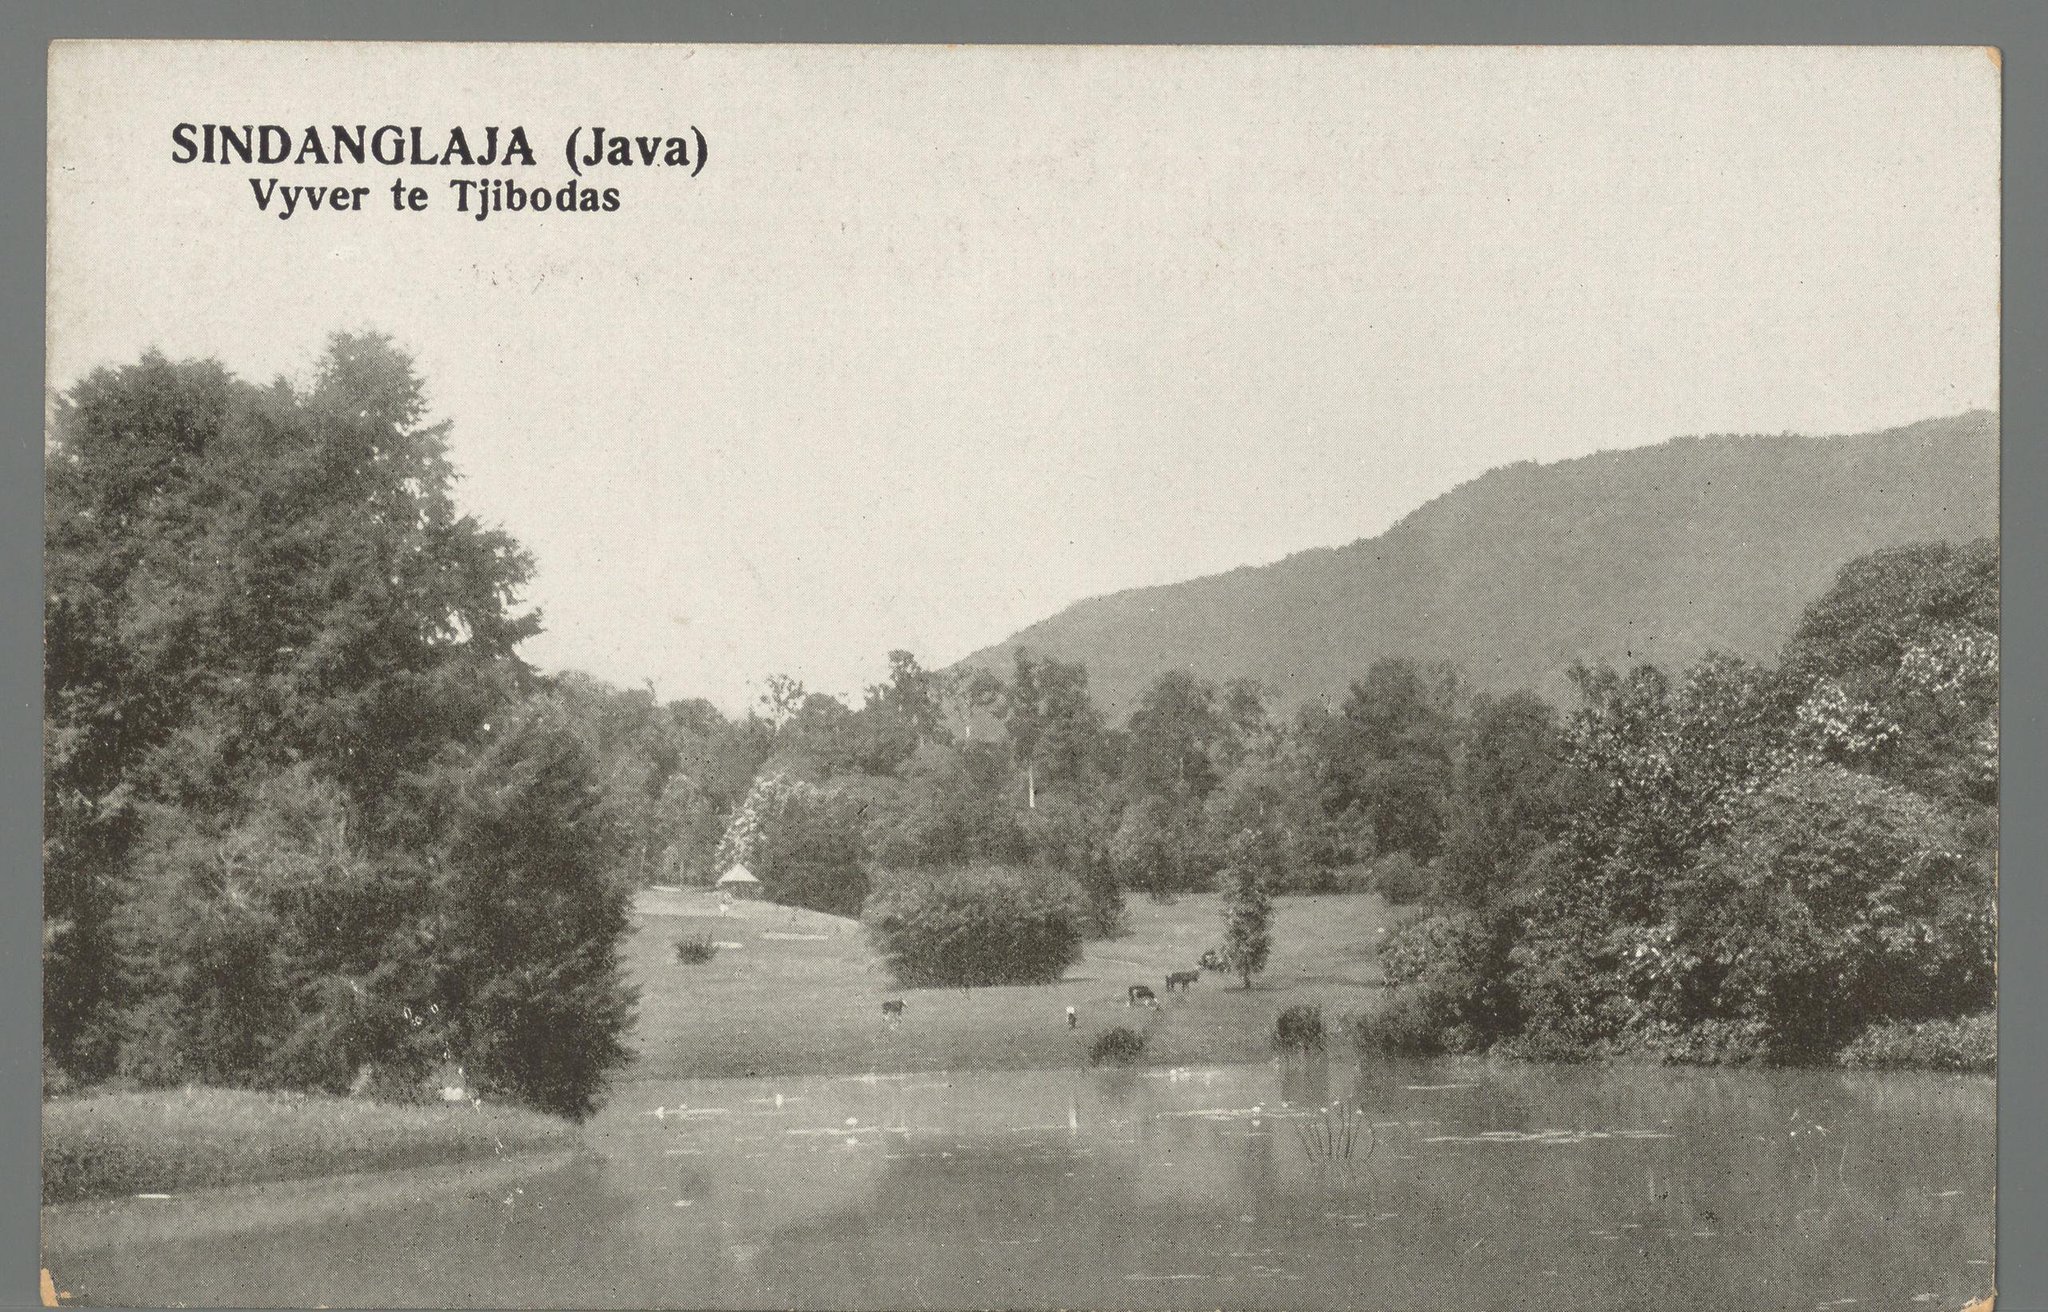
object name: ansichtkaart, prentbriefkaart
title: Sindanglaja (Java). Vyver te Tjibodas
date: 1906-1930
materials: cardboard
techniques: autotype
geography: weltevreden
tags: pond, mountains